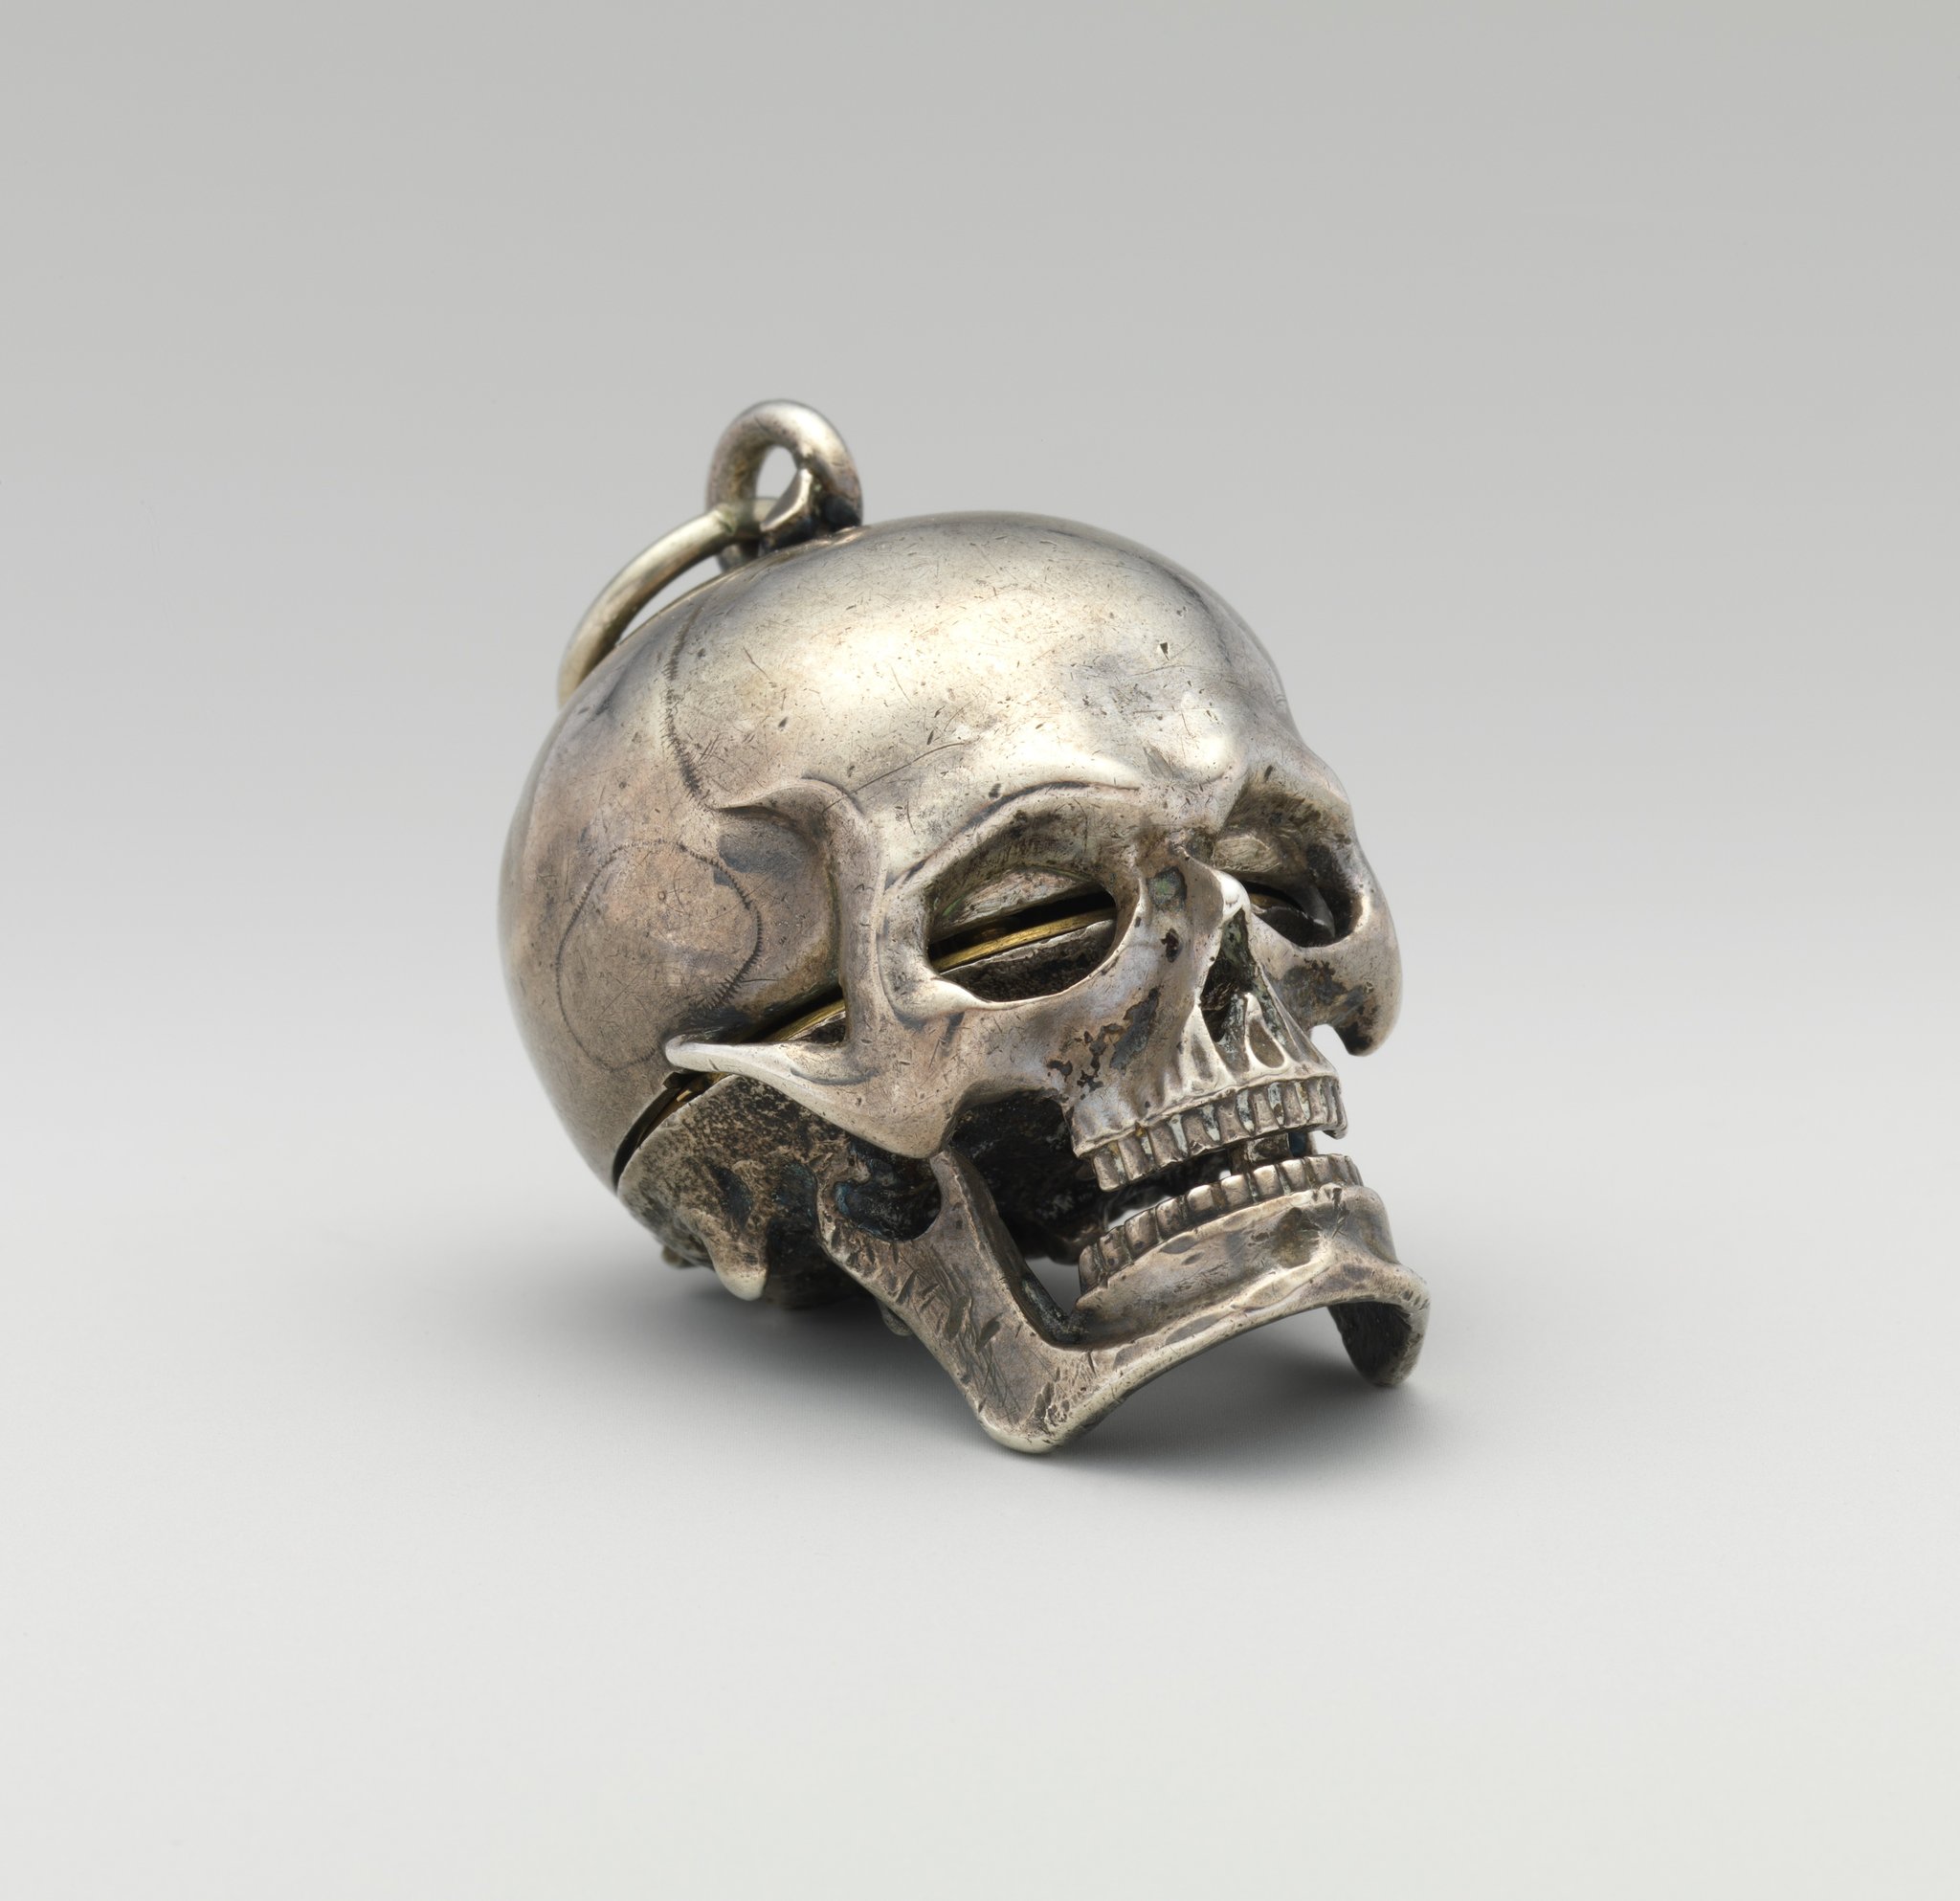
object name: watch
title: Watch in the form of a human skull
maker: isaac penard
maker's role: maker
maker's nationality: swiss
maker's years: 1619-1676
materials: gilt brass, silver, steel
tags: skulls